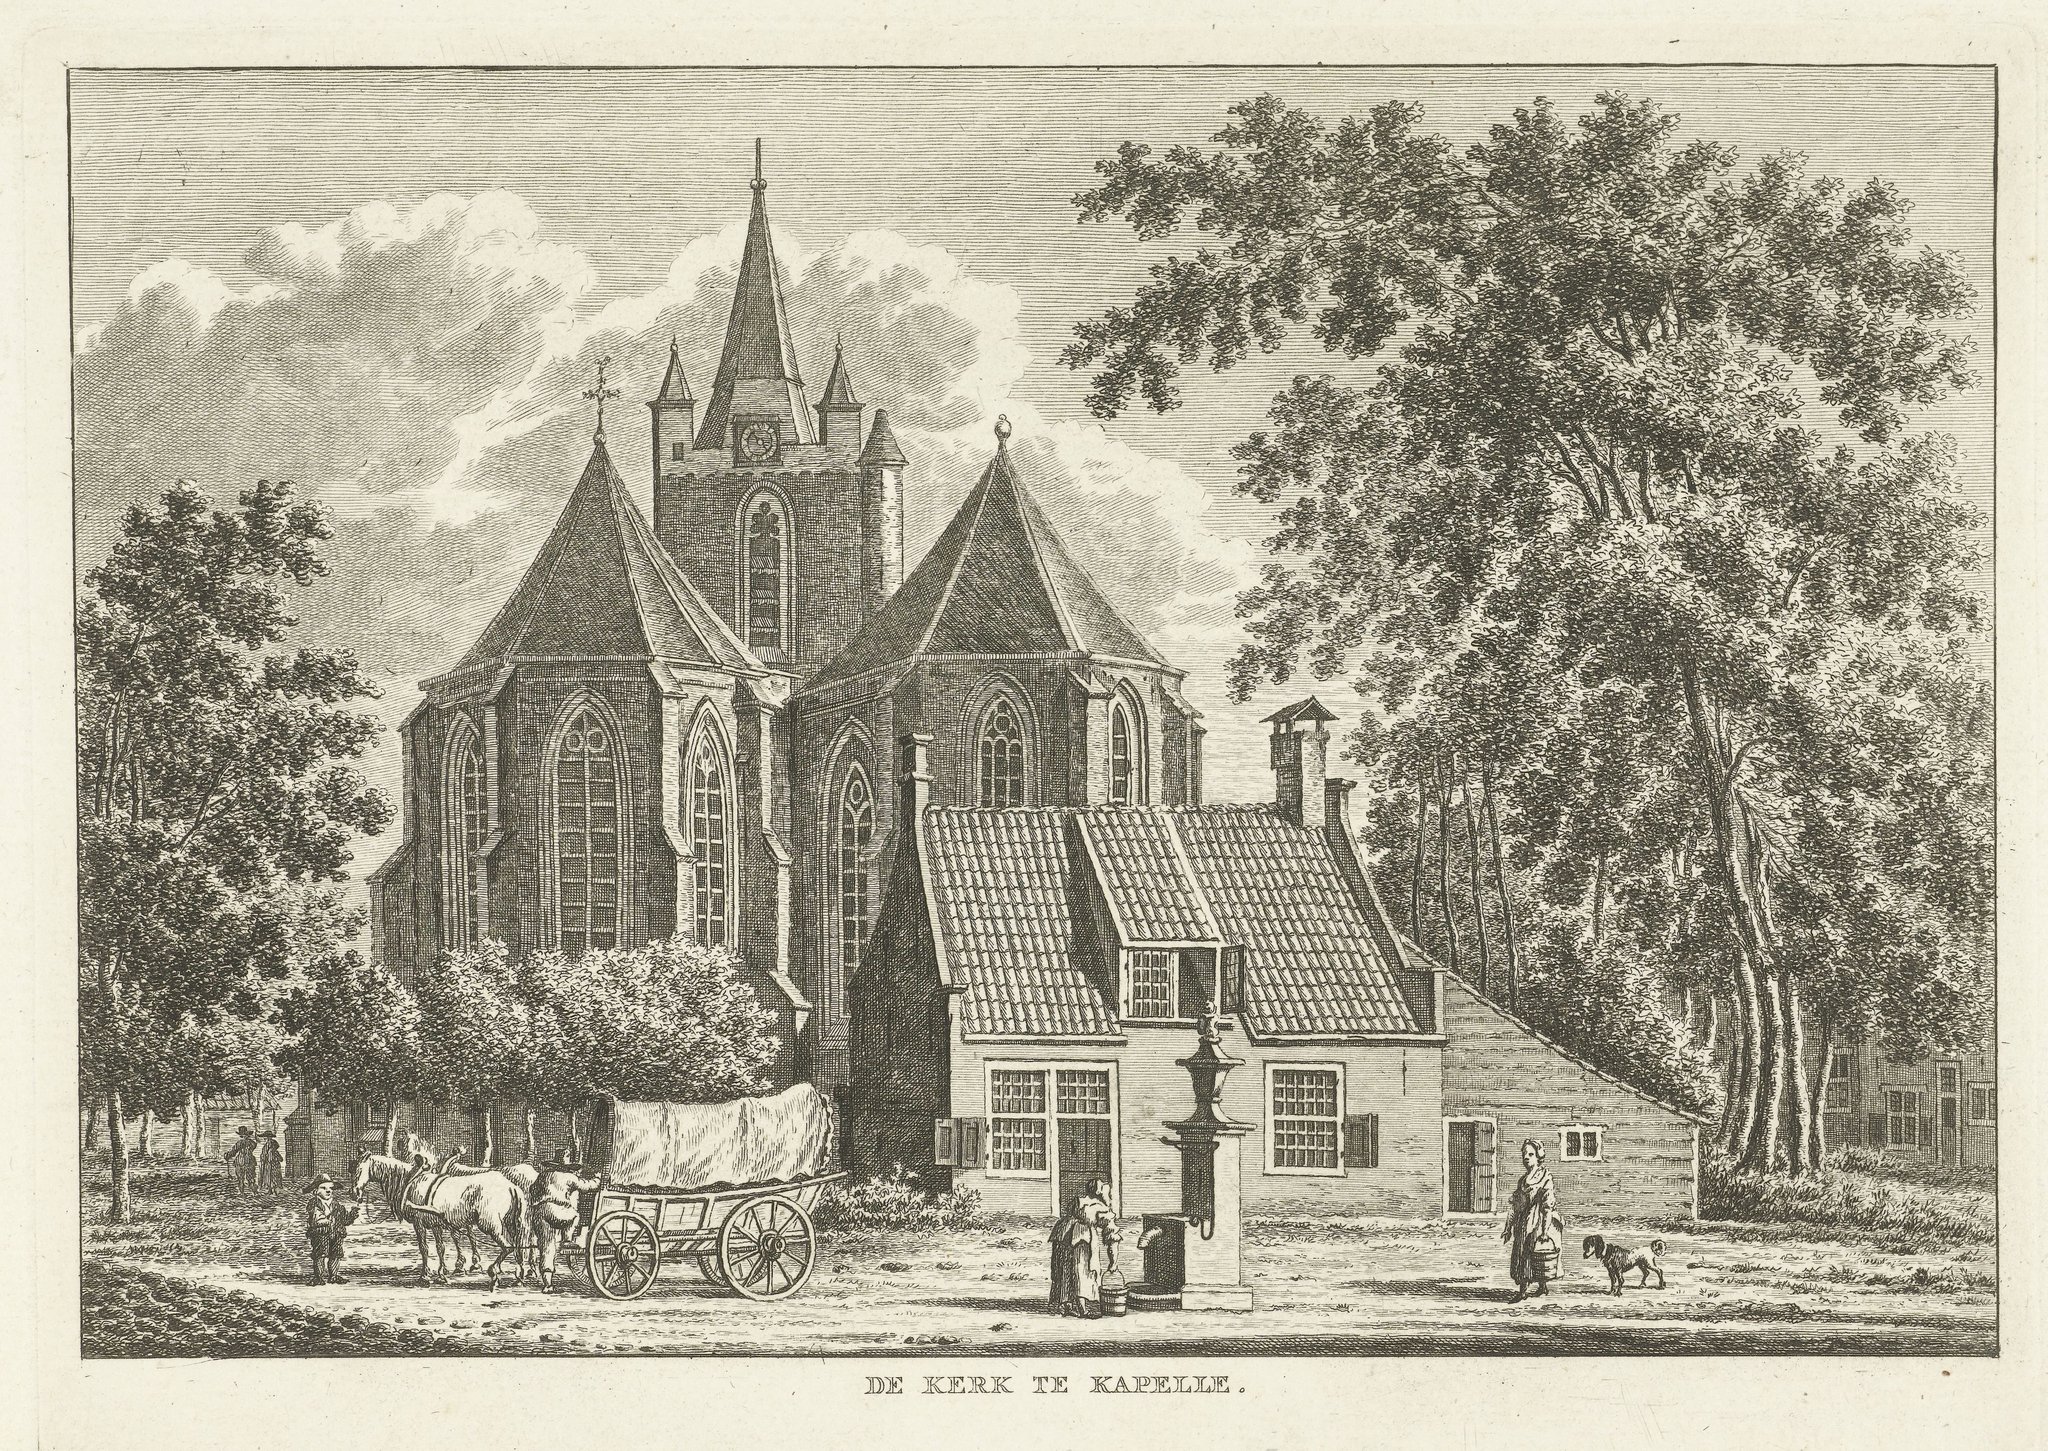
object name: print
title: De kerk te Kapelle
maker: carel frederik bendorp (i)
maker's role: print maker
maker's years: 1736-1814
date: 1786-1792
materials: paper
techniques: etching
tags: church (exterior)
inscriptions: collector's mark: Lugt 2228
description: Prent uit: Vaderlandsche gezichten, of afbeeldingen van den tegenwoordigen staat der Vereenigde Nederlanden (…). Amsterdam: Hendrik Gartman, Willem Vermandel en Jan Willem Smit, 1786-1792. Uitgegeven in afleveringen met ieder een eigen bifolium en inhoudsopgave. Alle prenten in deze publicatie zijn gegraveerd door Carel Frederik Bendorp (I) en, in de meeste gevallen, gebaseerd op tekeningen van Jan Bulthuis.